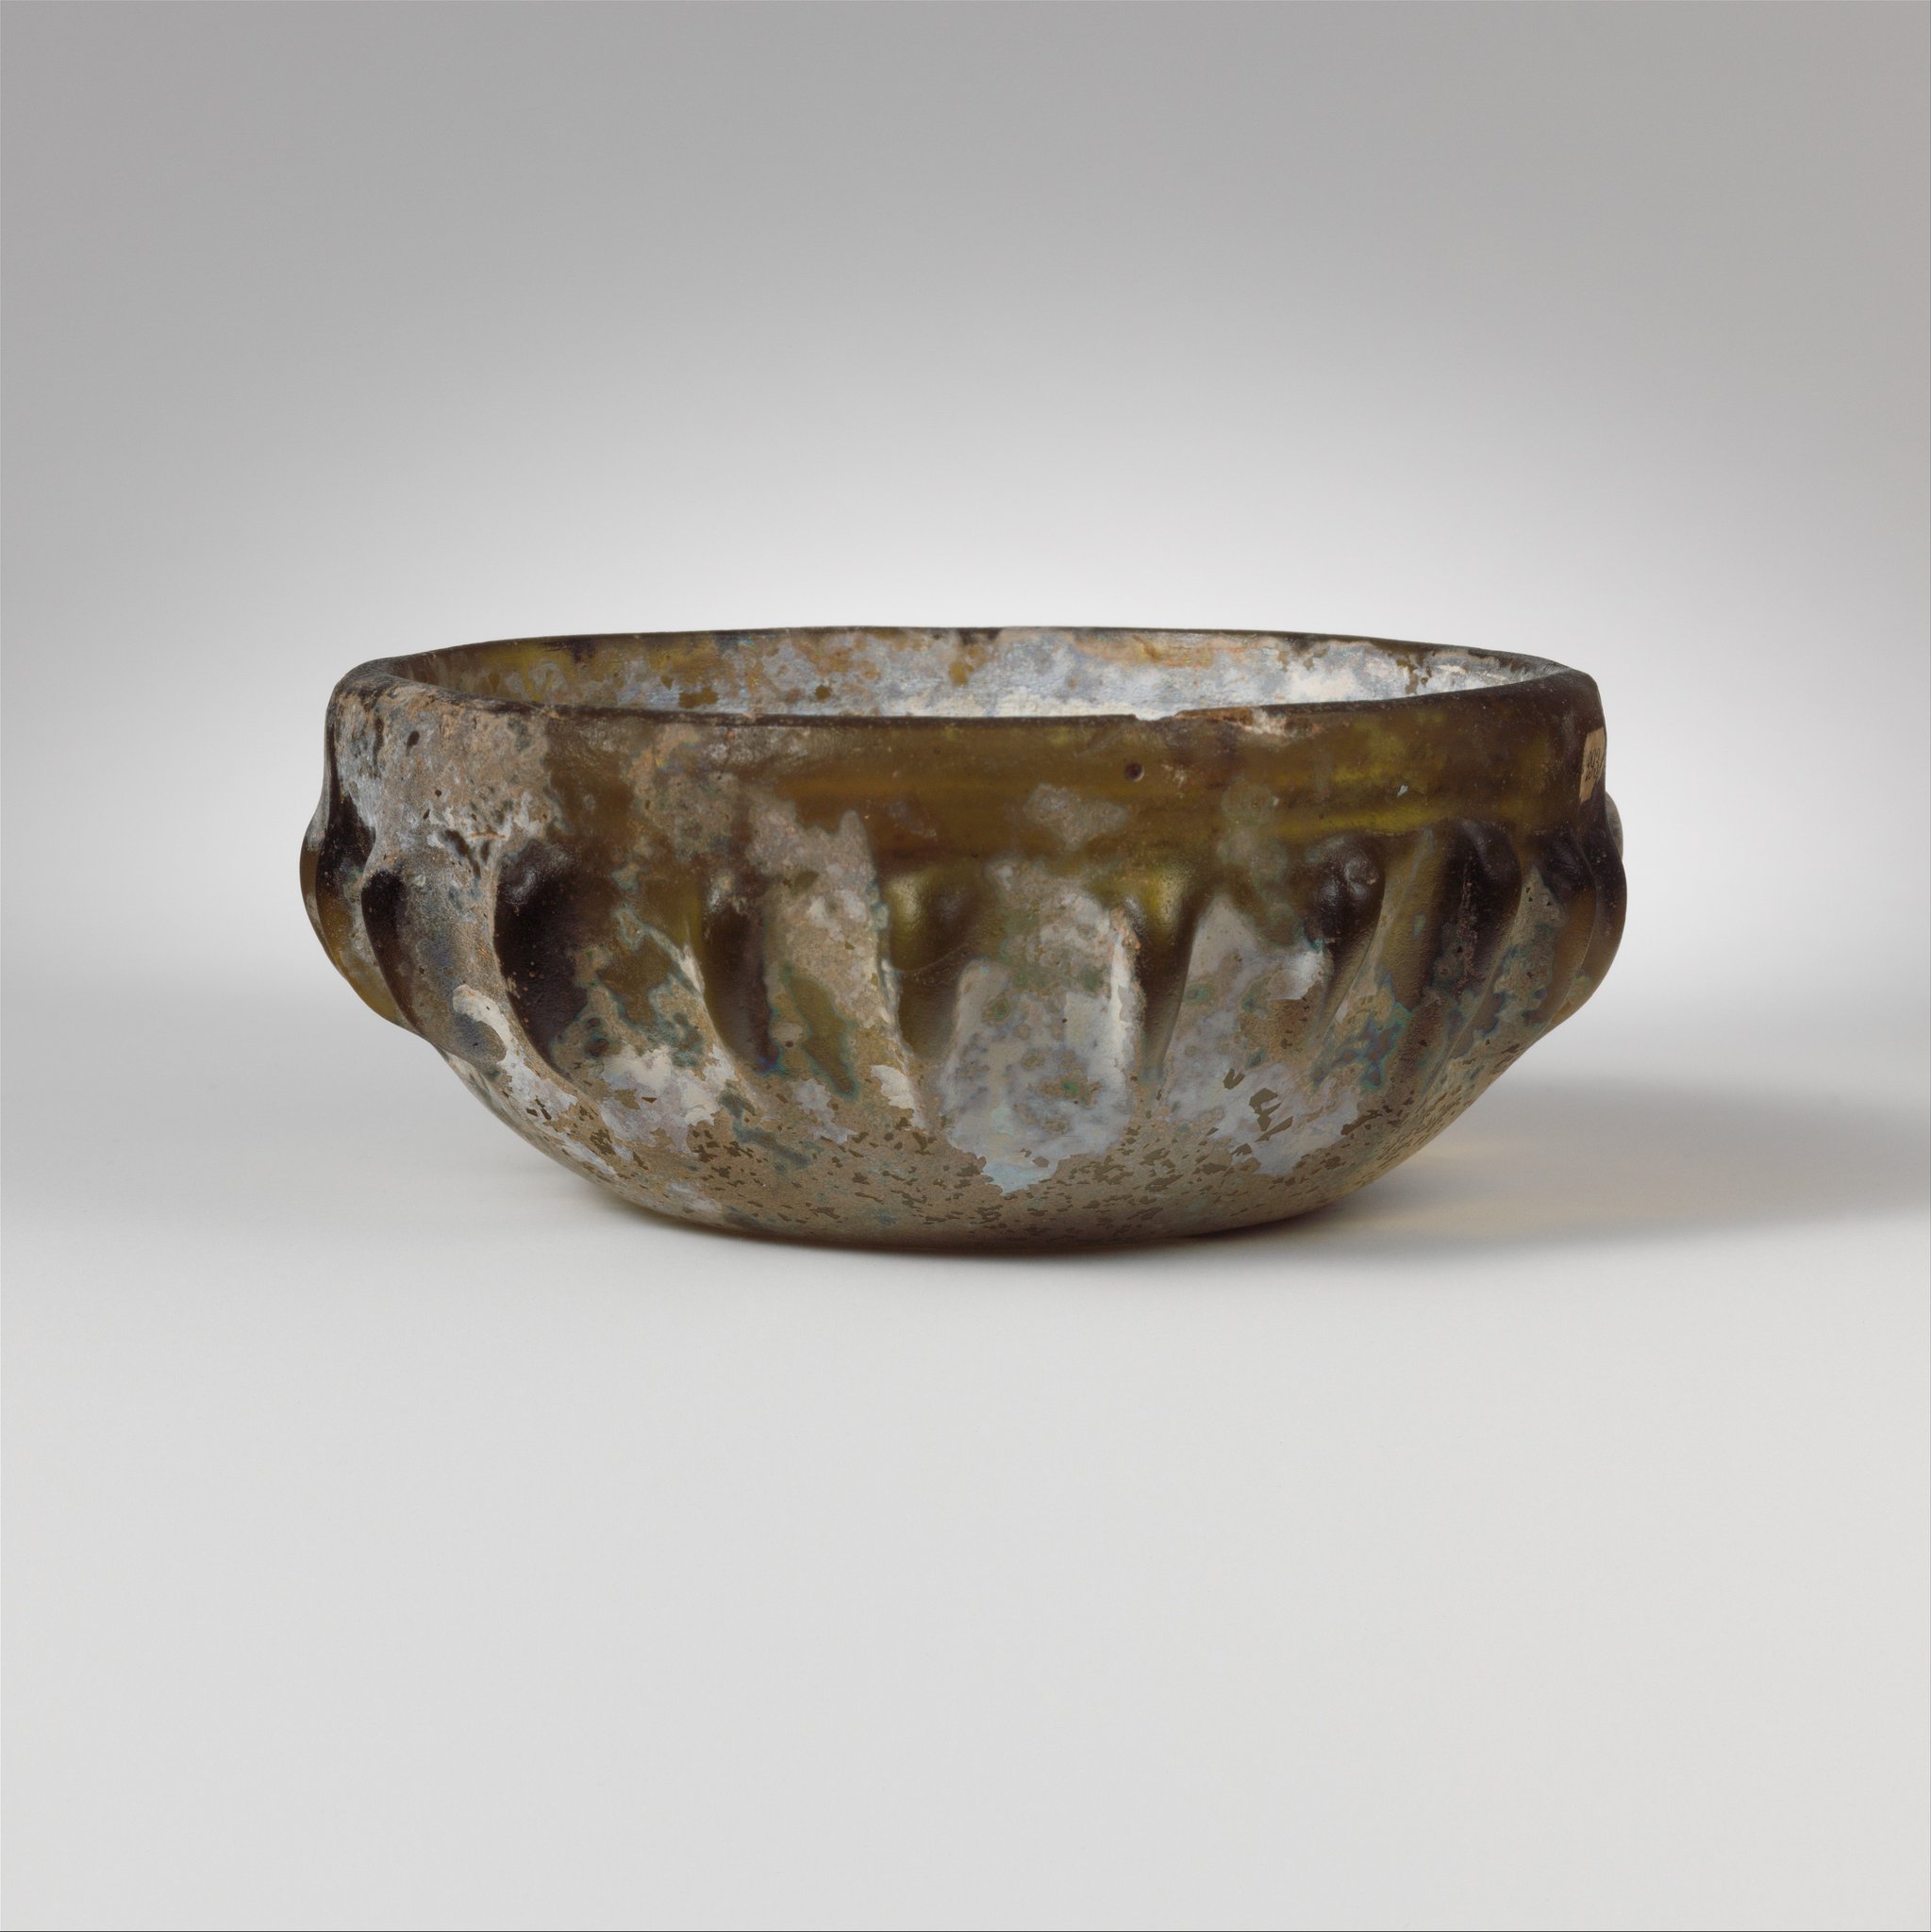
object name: bowl, ribbed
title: Glass ribbed bowl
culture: greek, eastern mediterranean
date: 100-1 BCE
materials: glass